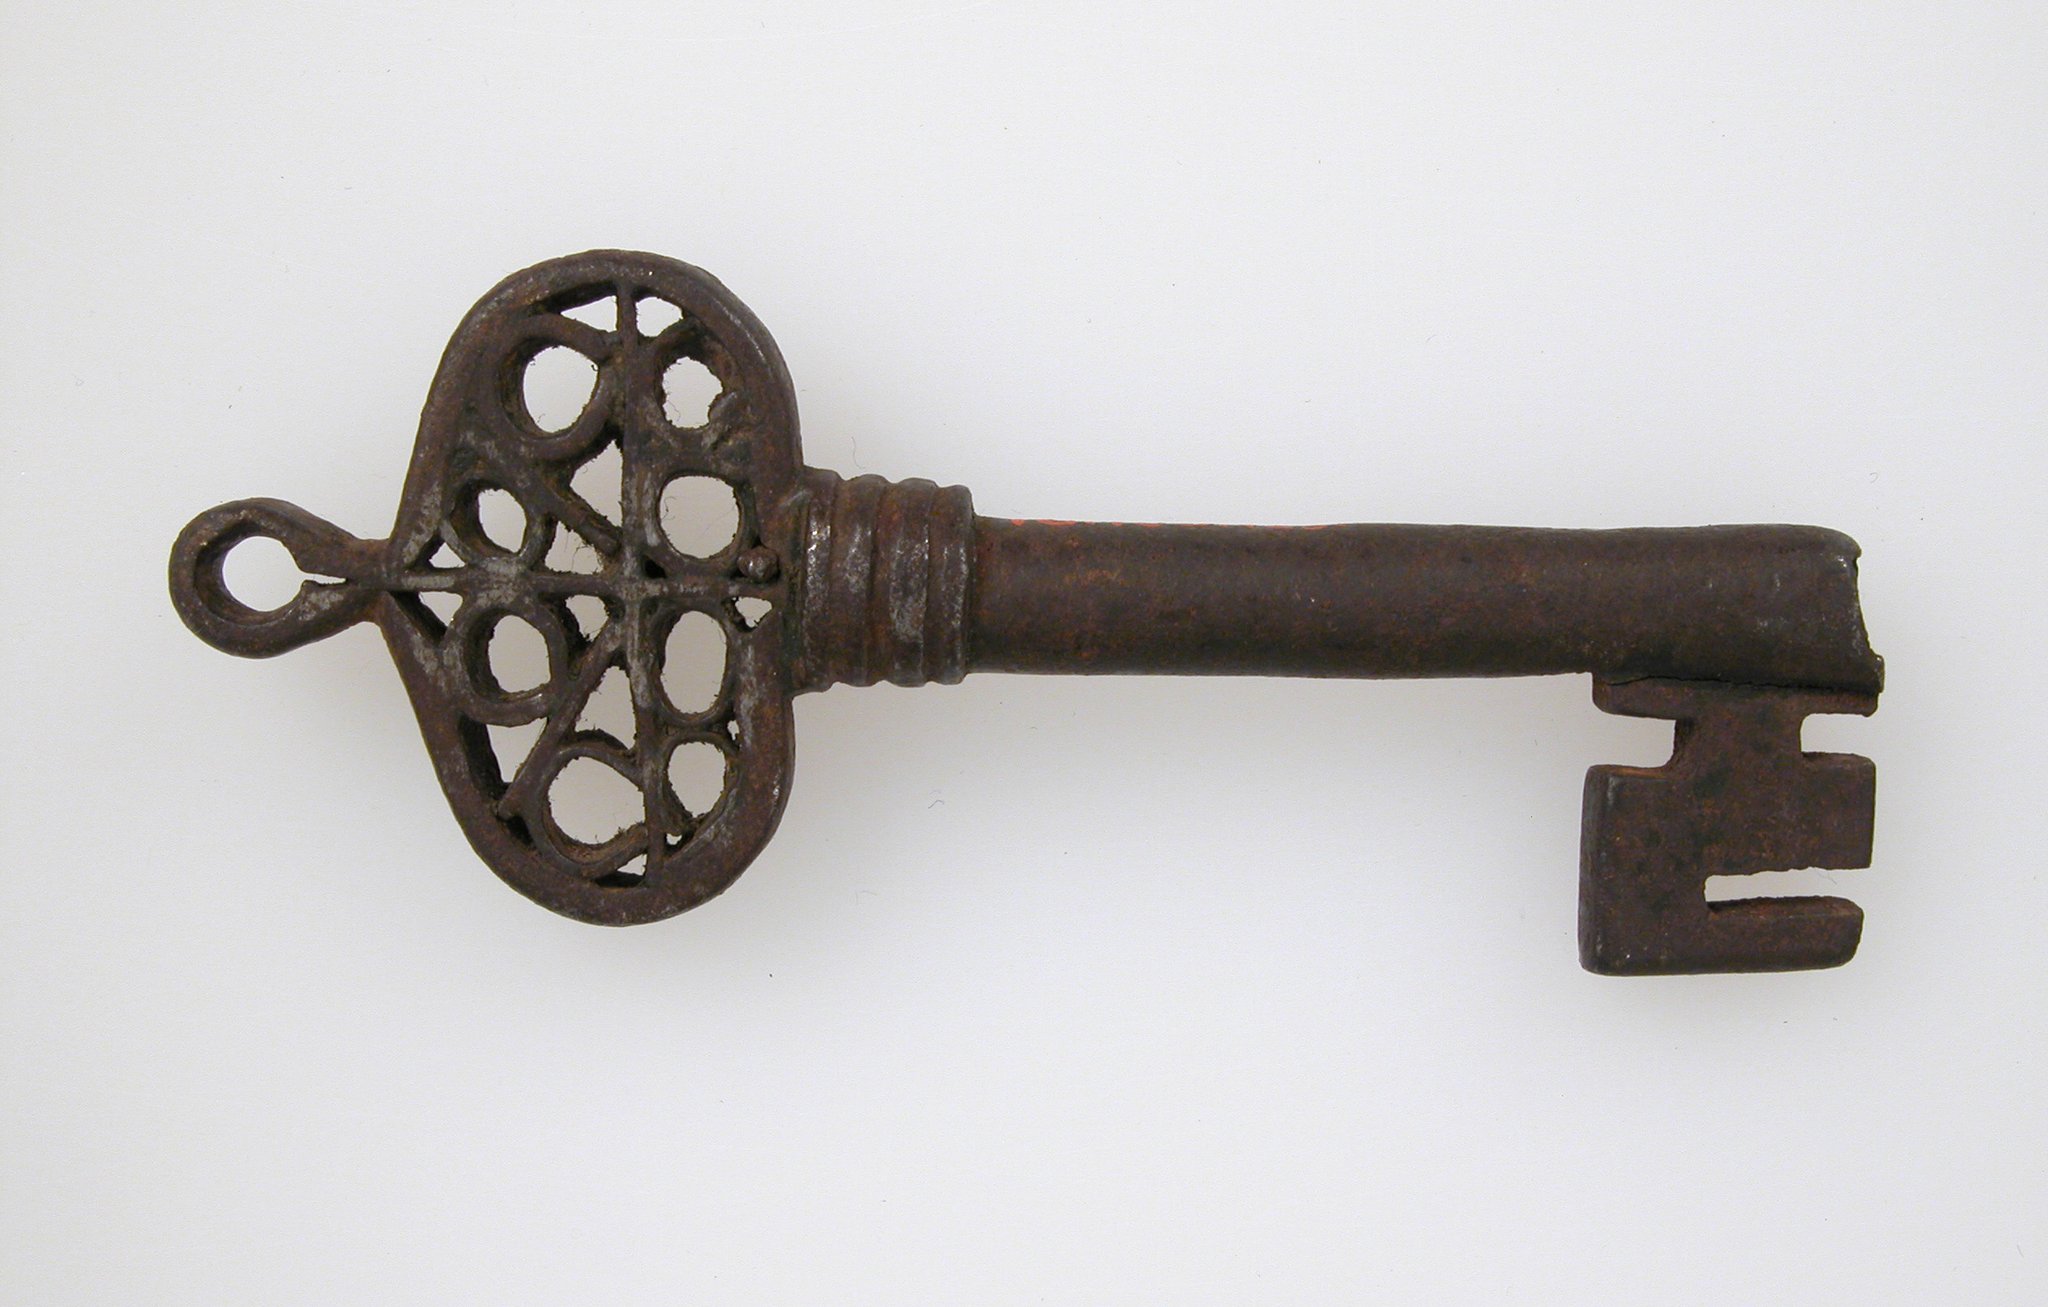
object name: key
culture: german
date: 1401-1500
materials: iron